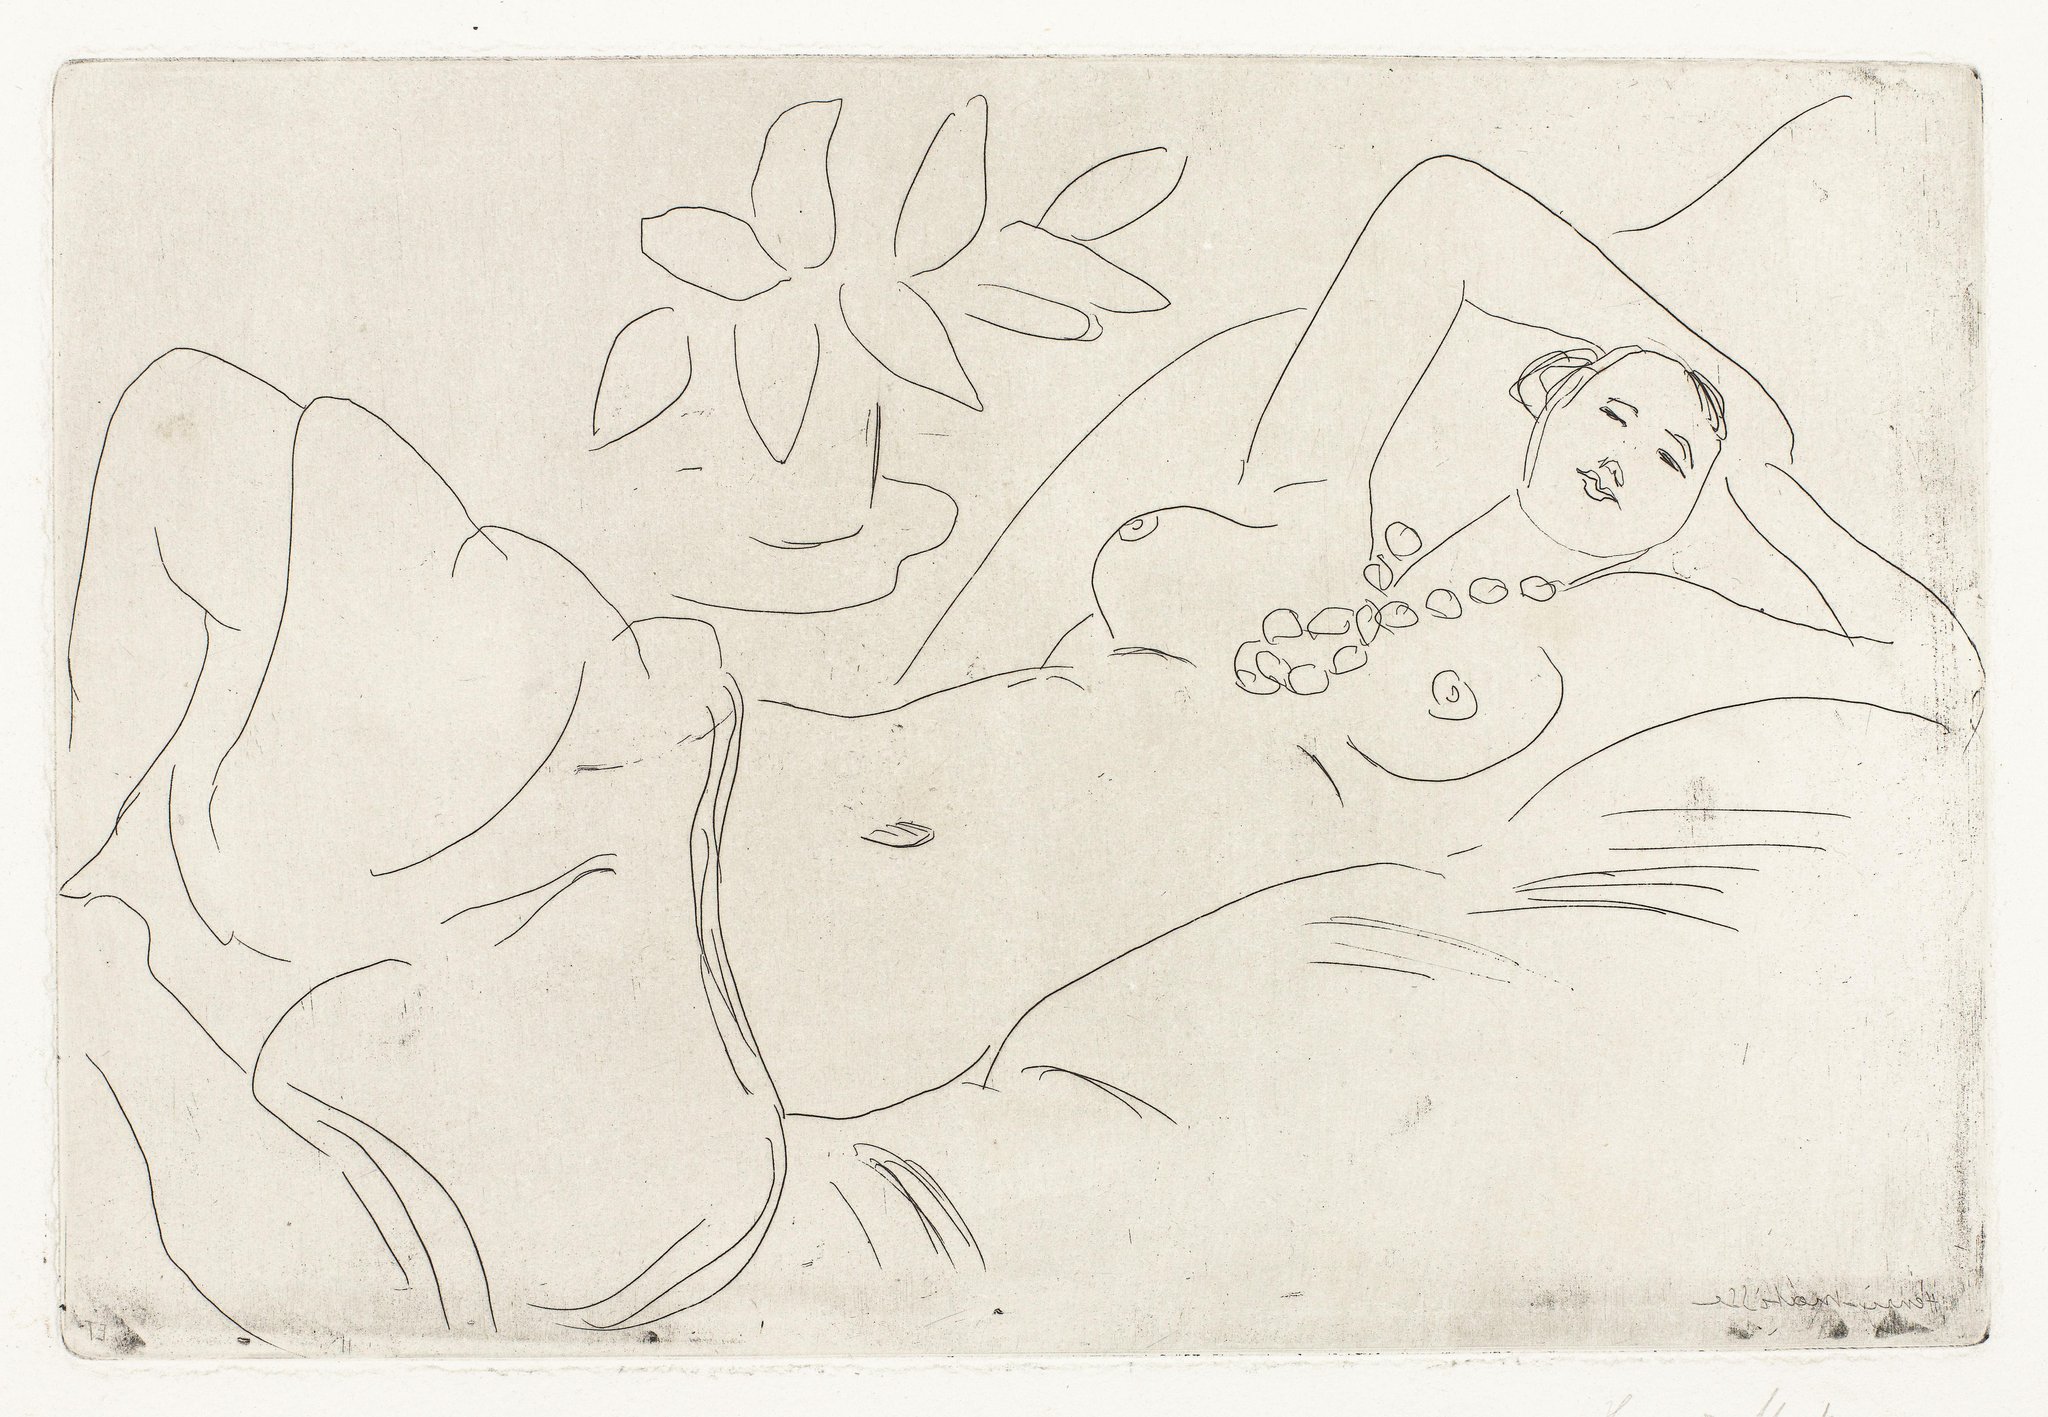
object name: print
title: Liggende odaliske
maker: henri matisse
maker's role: print maker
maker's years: 1869-1954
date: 1923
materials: paper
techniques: etching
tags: odalisque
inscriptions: collector's mark: Lugt 2228